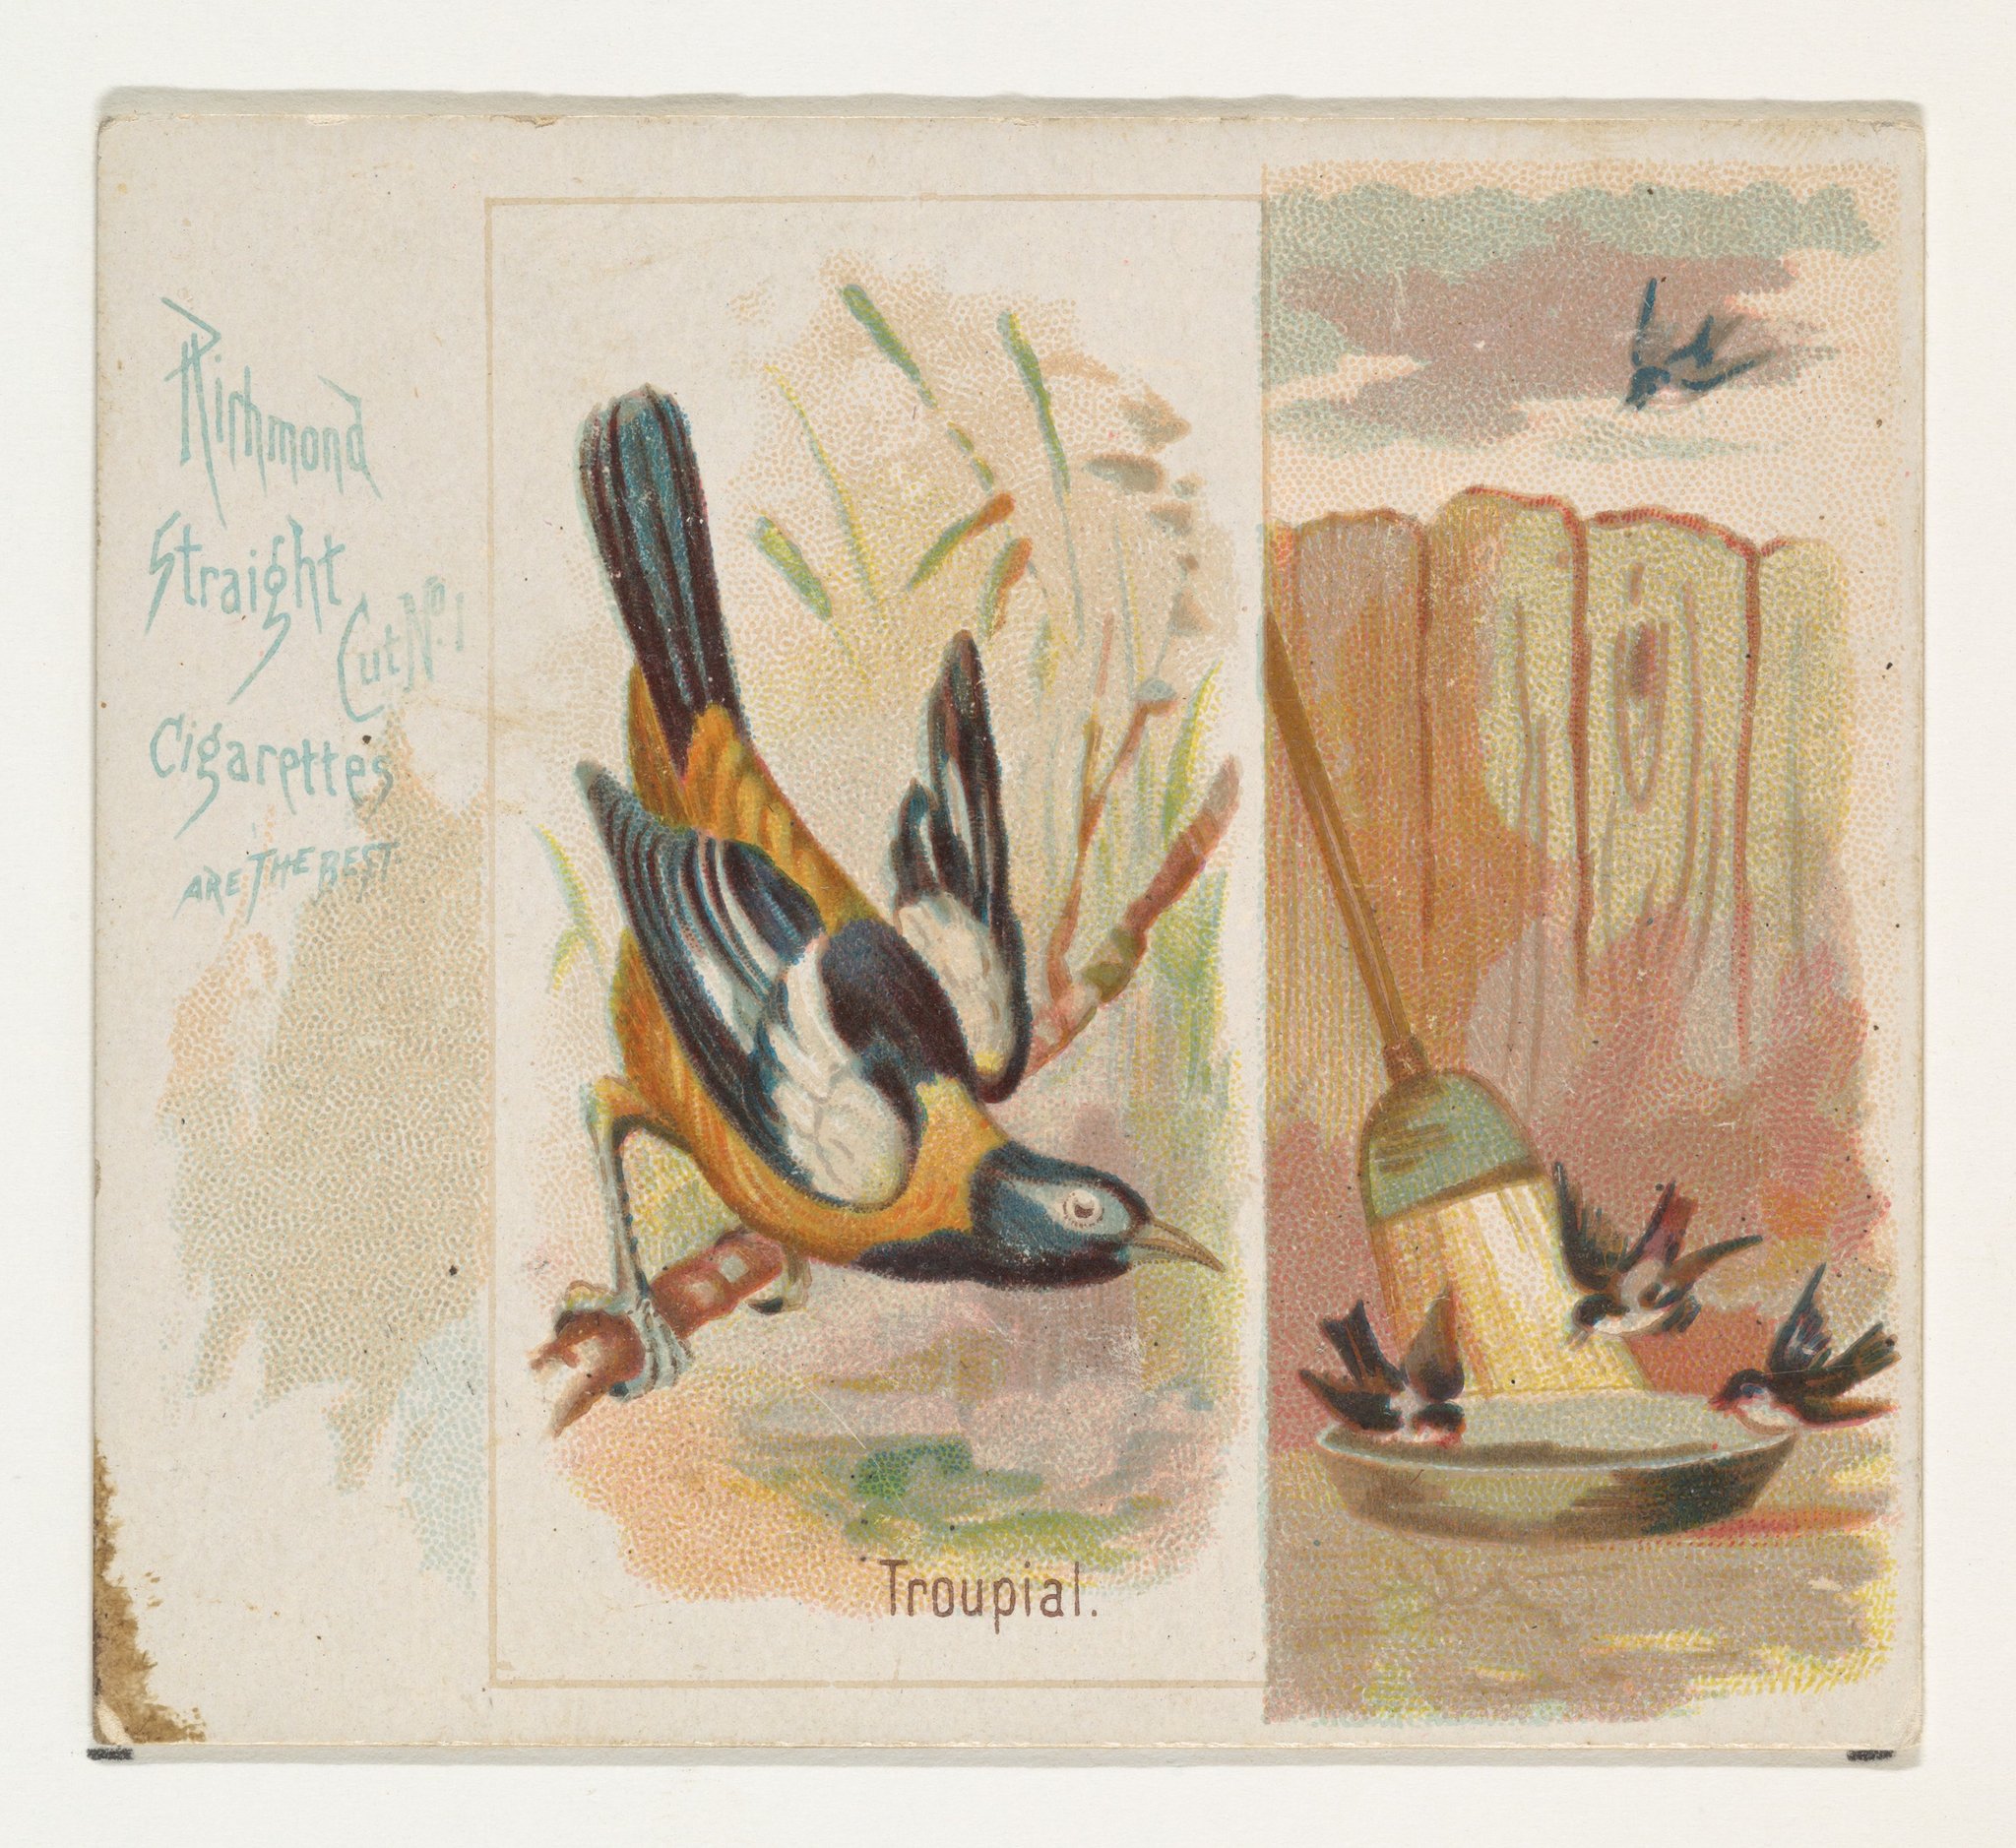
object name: print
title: Troupial, from the Song Birds of the World series (N42) for Allen & Ginter Cigarettes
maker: allen & ginter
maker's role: publisher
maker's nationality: american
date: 1890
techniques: color lithograph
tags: birds